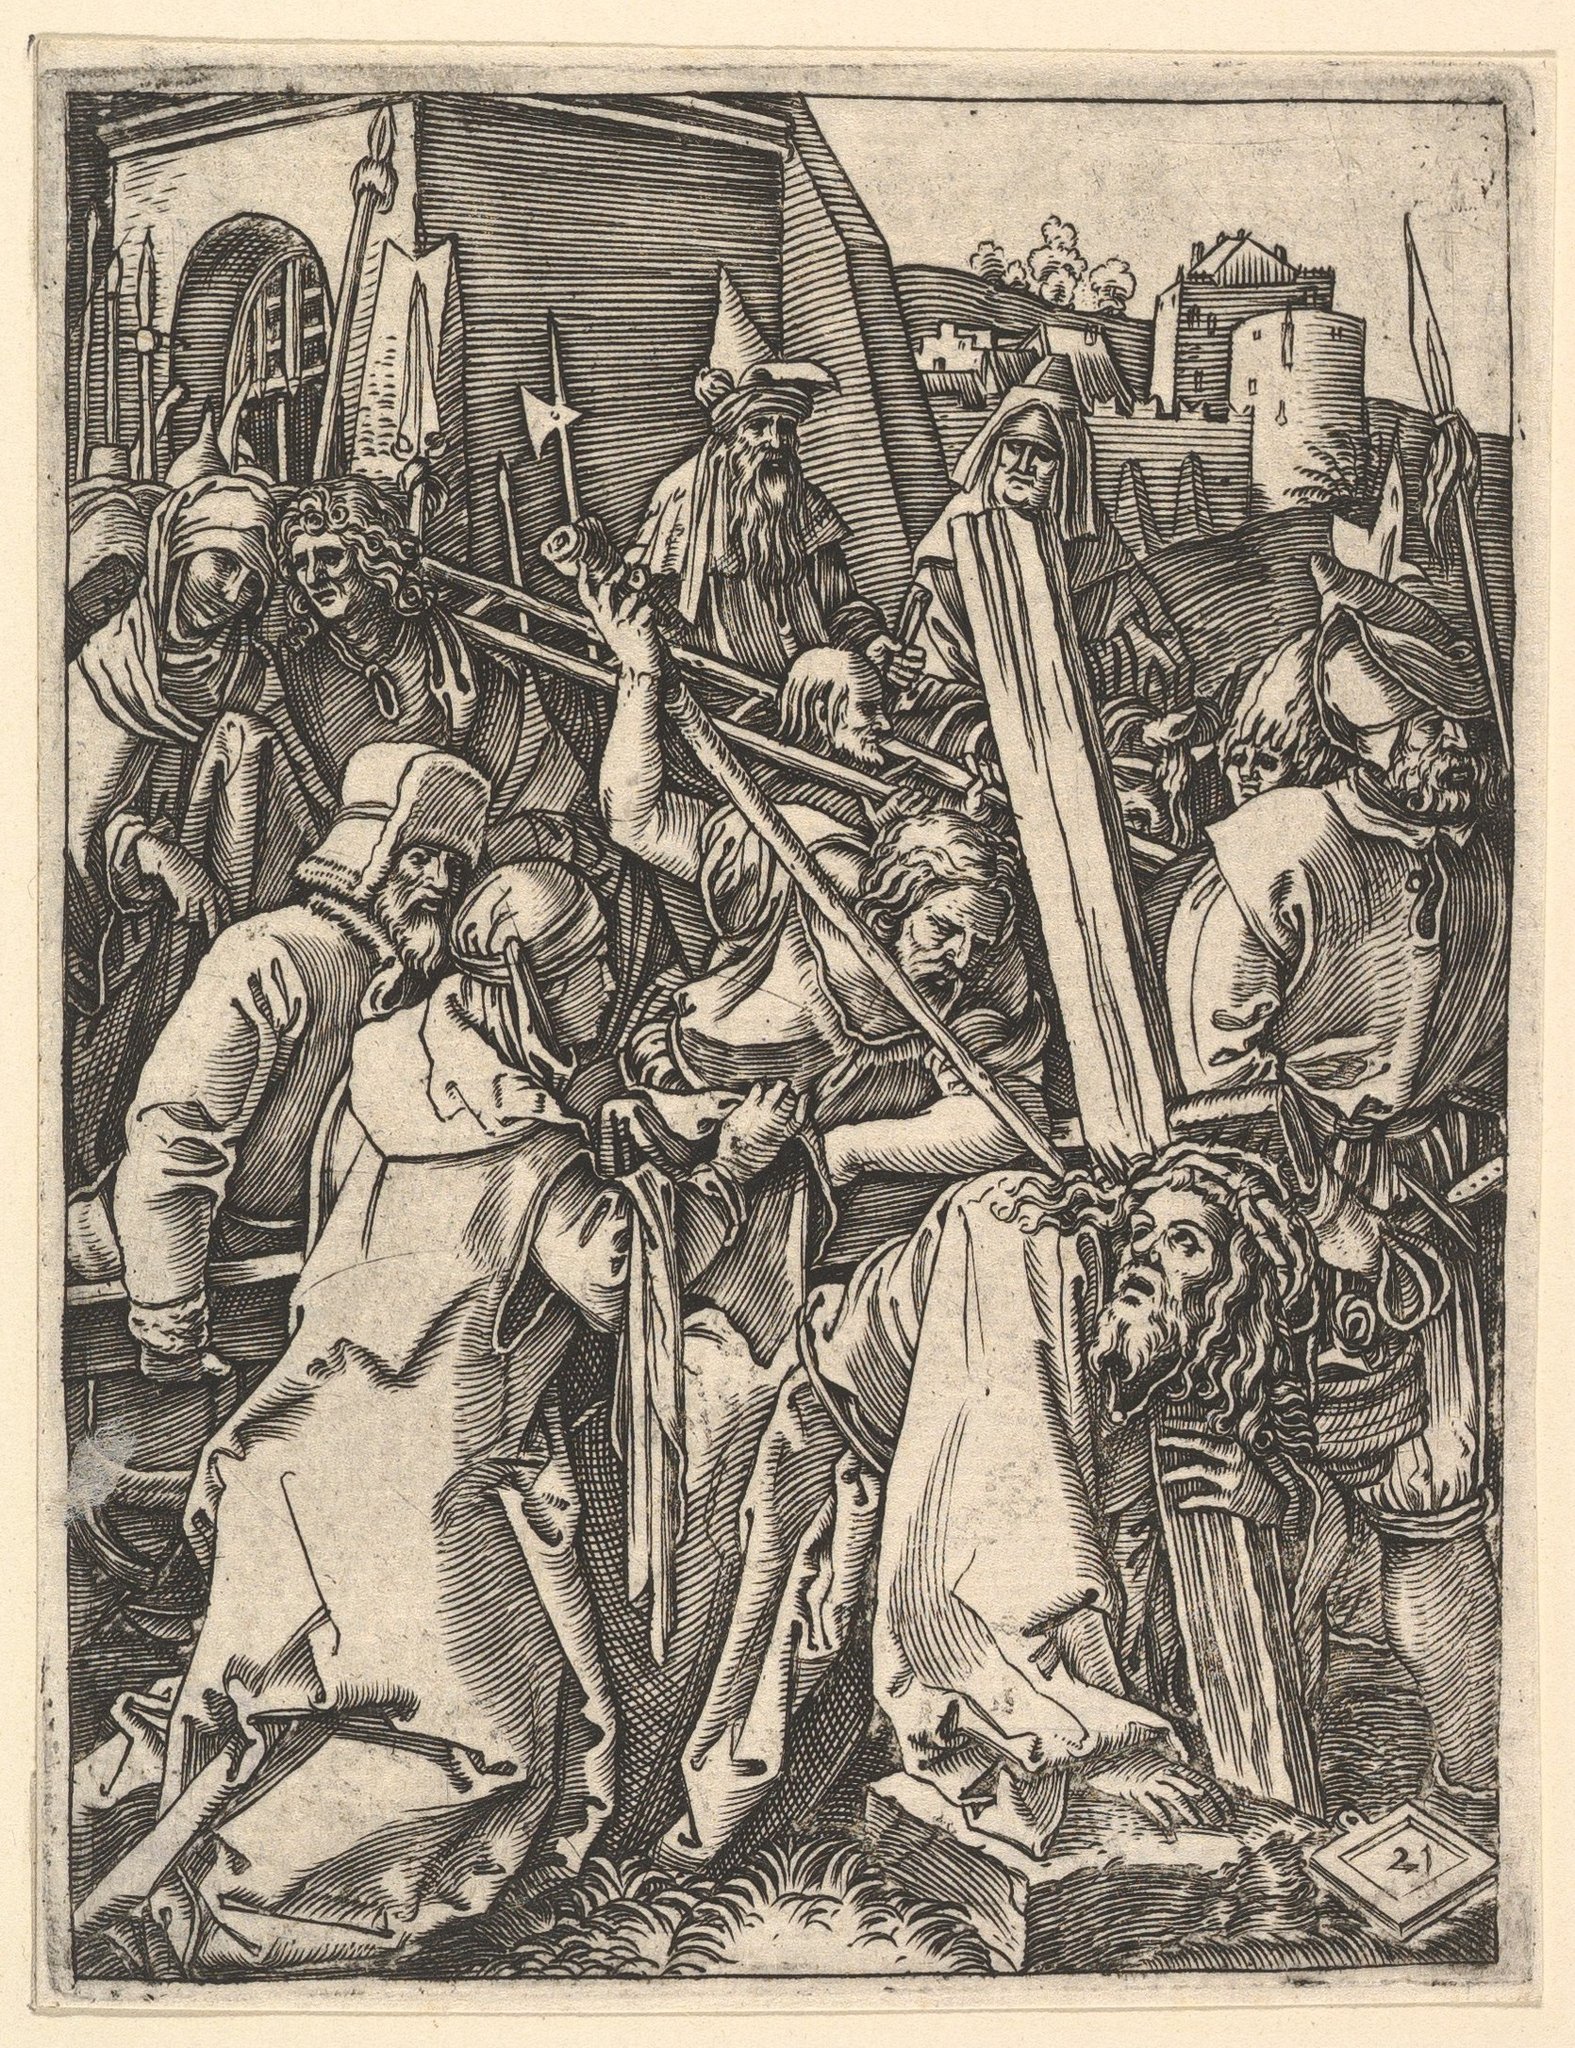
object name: print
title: The Bearing of the Cross; Christ bearing the cross, supporting himself with one arm on the ground, from "The Passion of Christ", after Dürer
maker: marcantonio raimondi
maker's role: artist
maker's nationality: italian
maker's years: 1475-1534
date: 1500-1534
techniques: engraving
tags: weapons,suffering,men,christ,cross